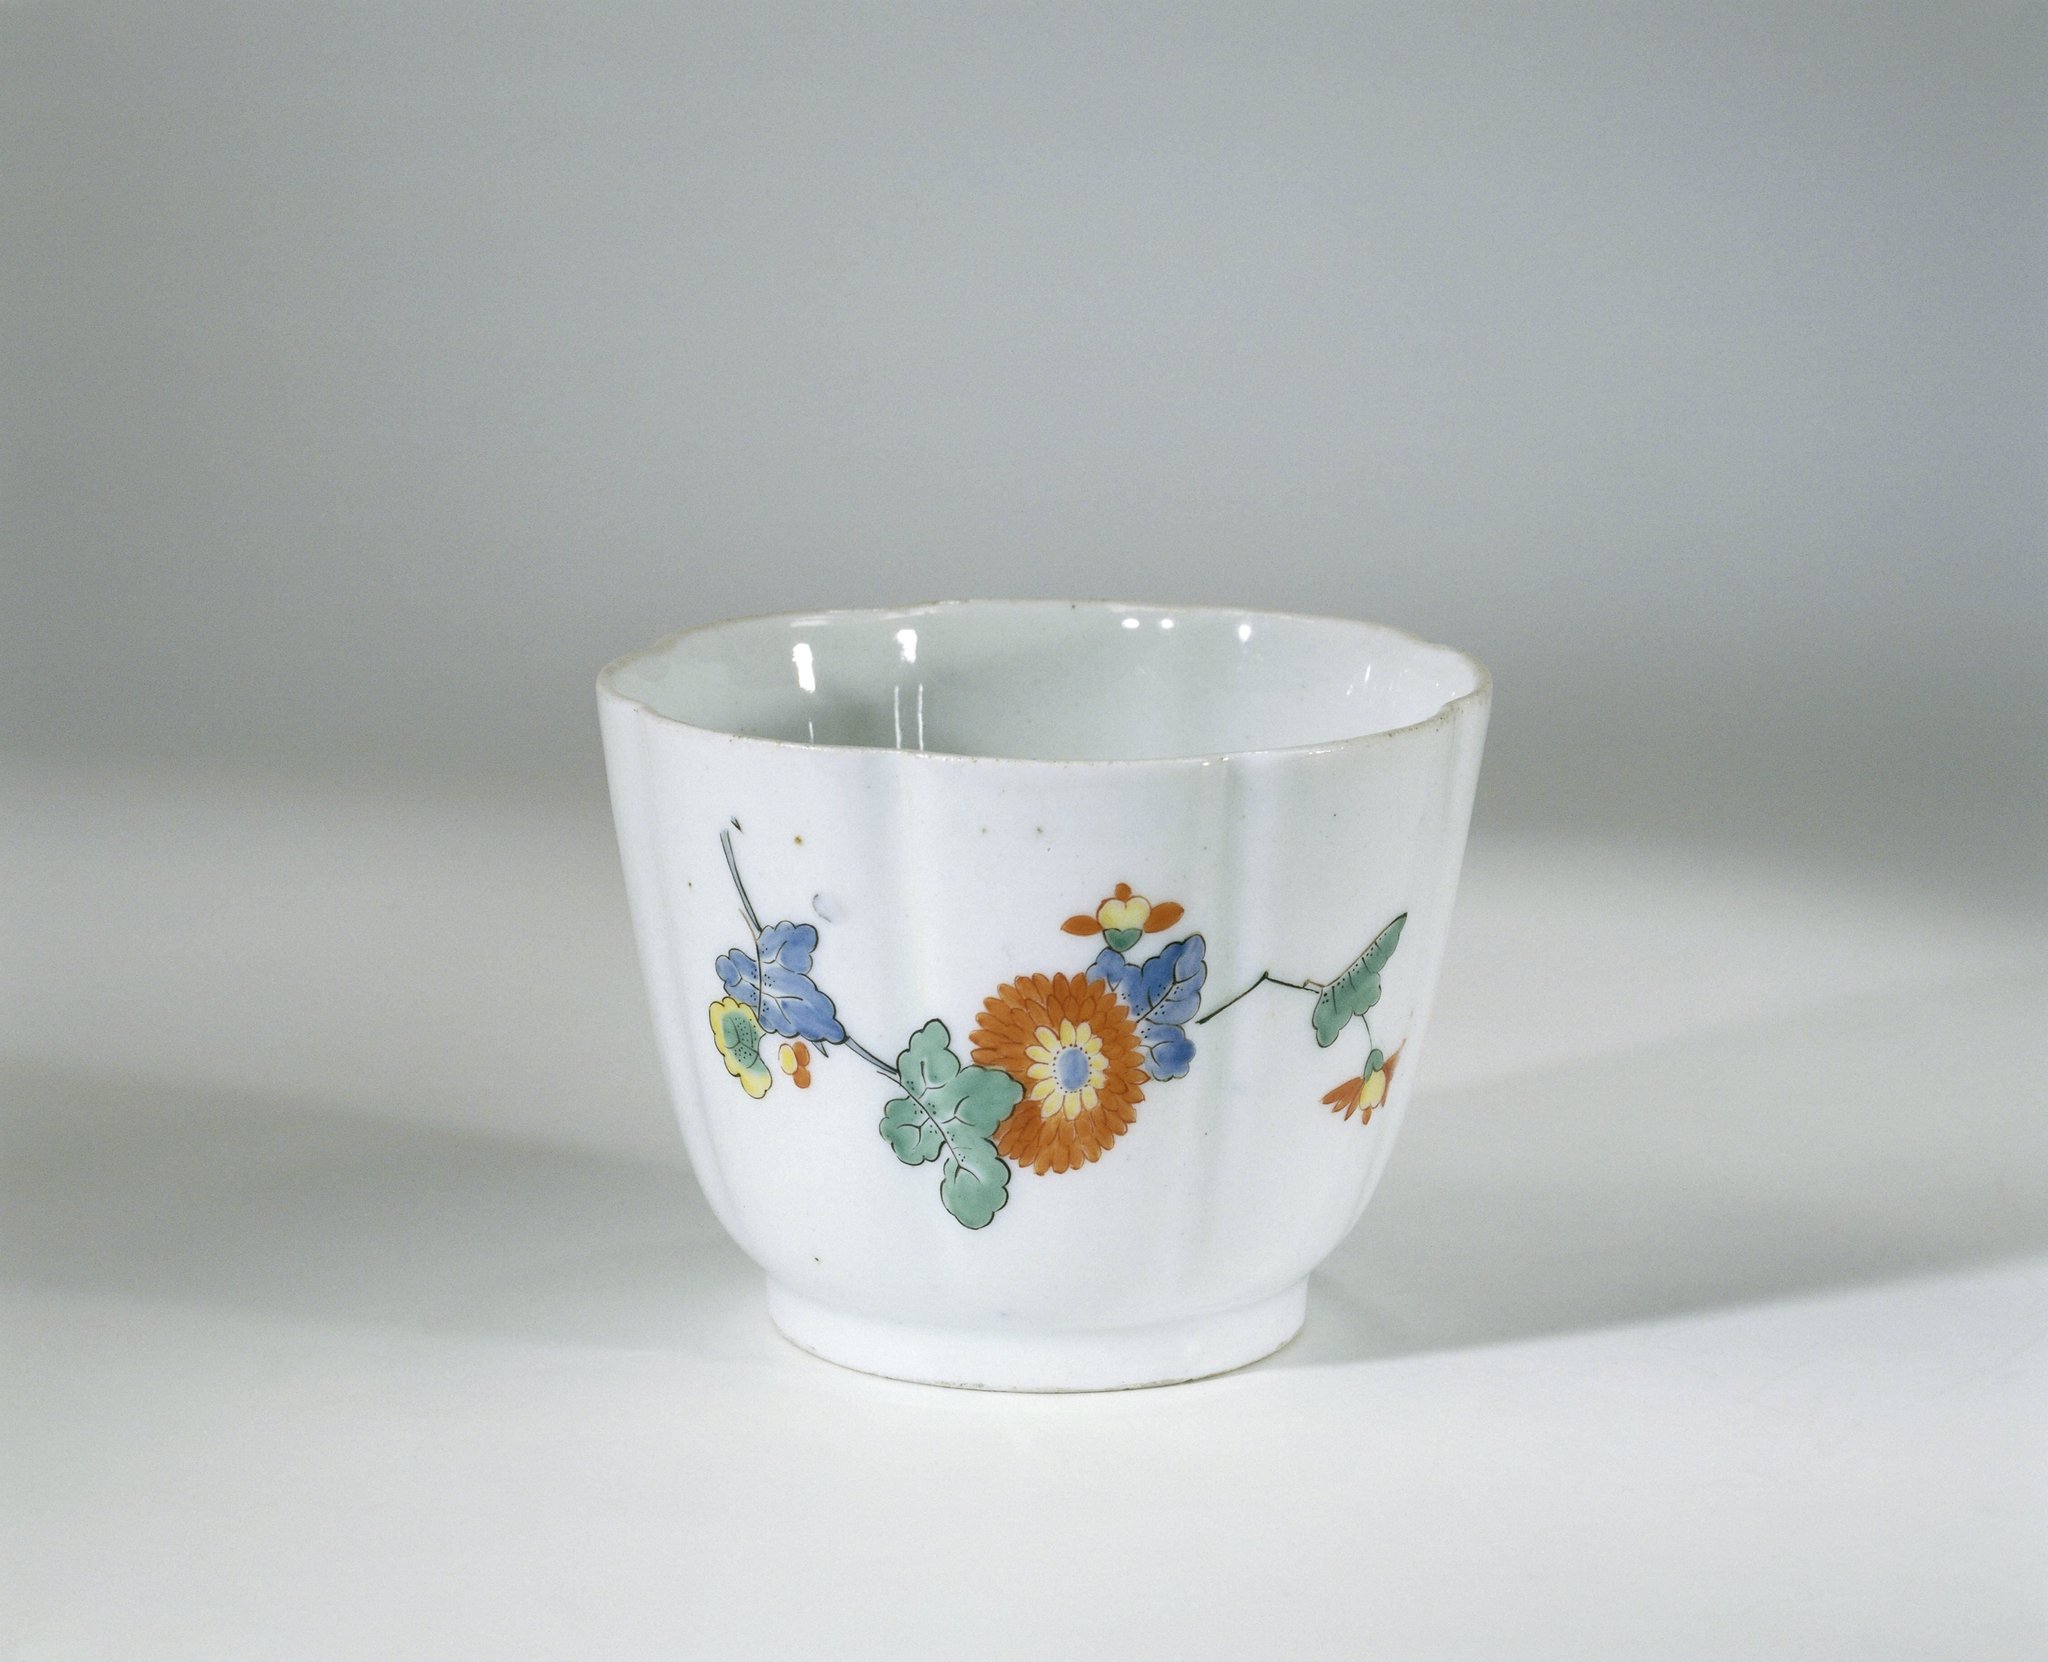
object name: cup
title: Kop, veelkleurig beschilderd met een Kakiemon-decor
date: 1730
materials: porcelain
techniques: painted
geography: meissen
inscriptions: factory mark, mold mark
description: Cup Meissen, c. 1725 - 1735 From the collection of August the Strong of Saxony, with the Dresden Palace inventory number N=339